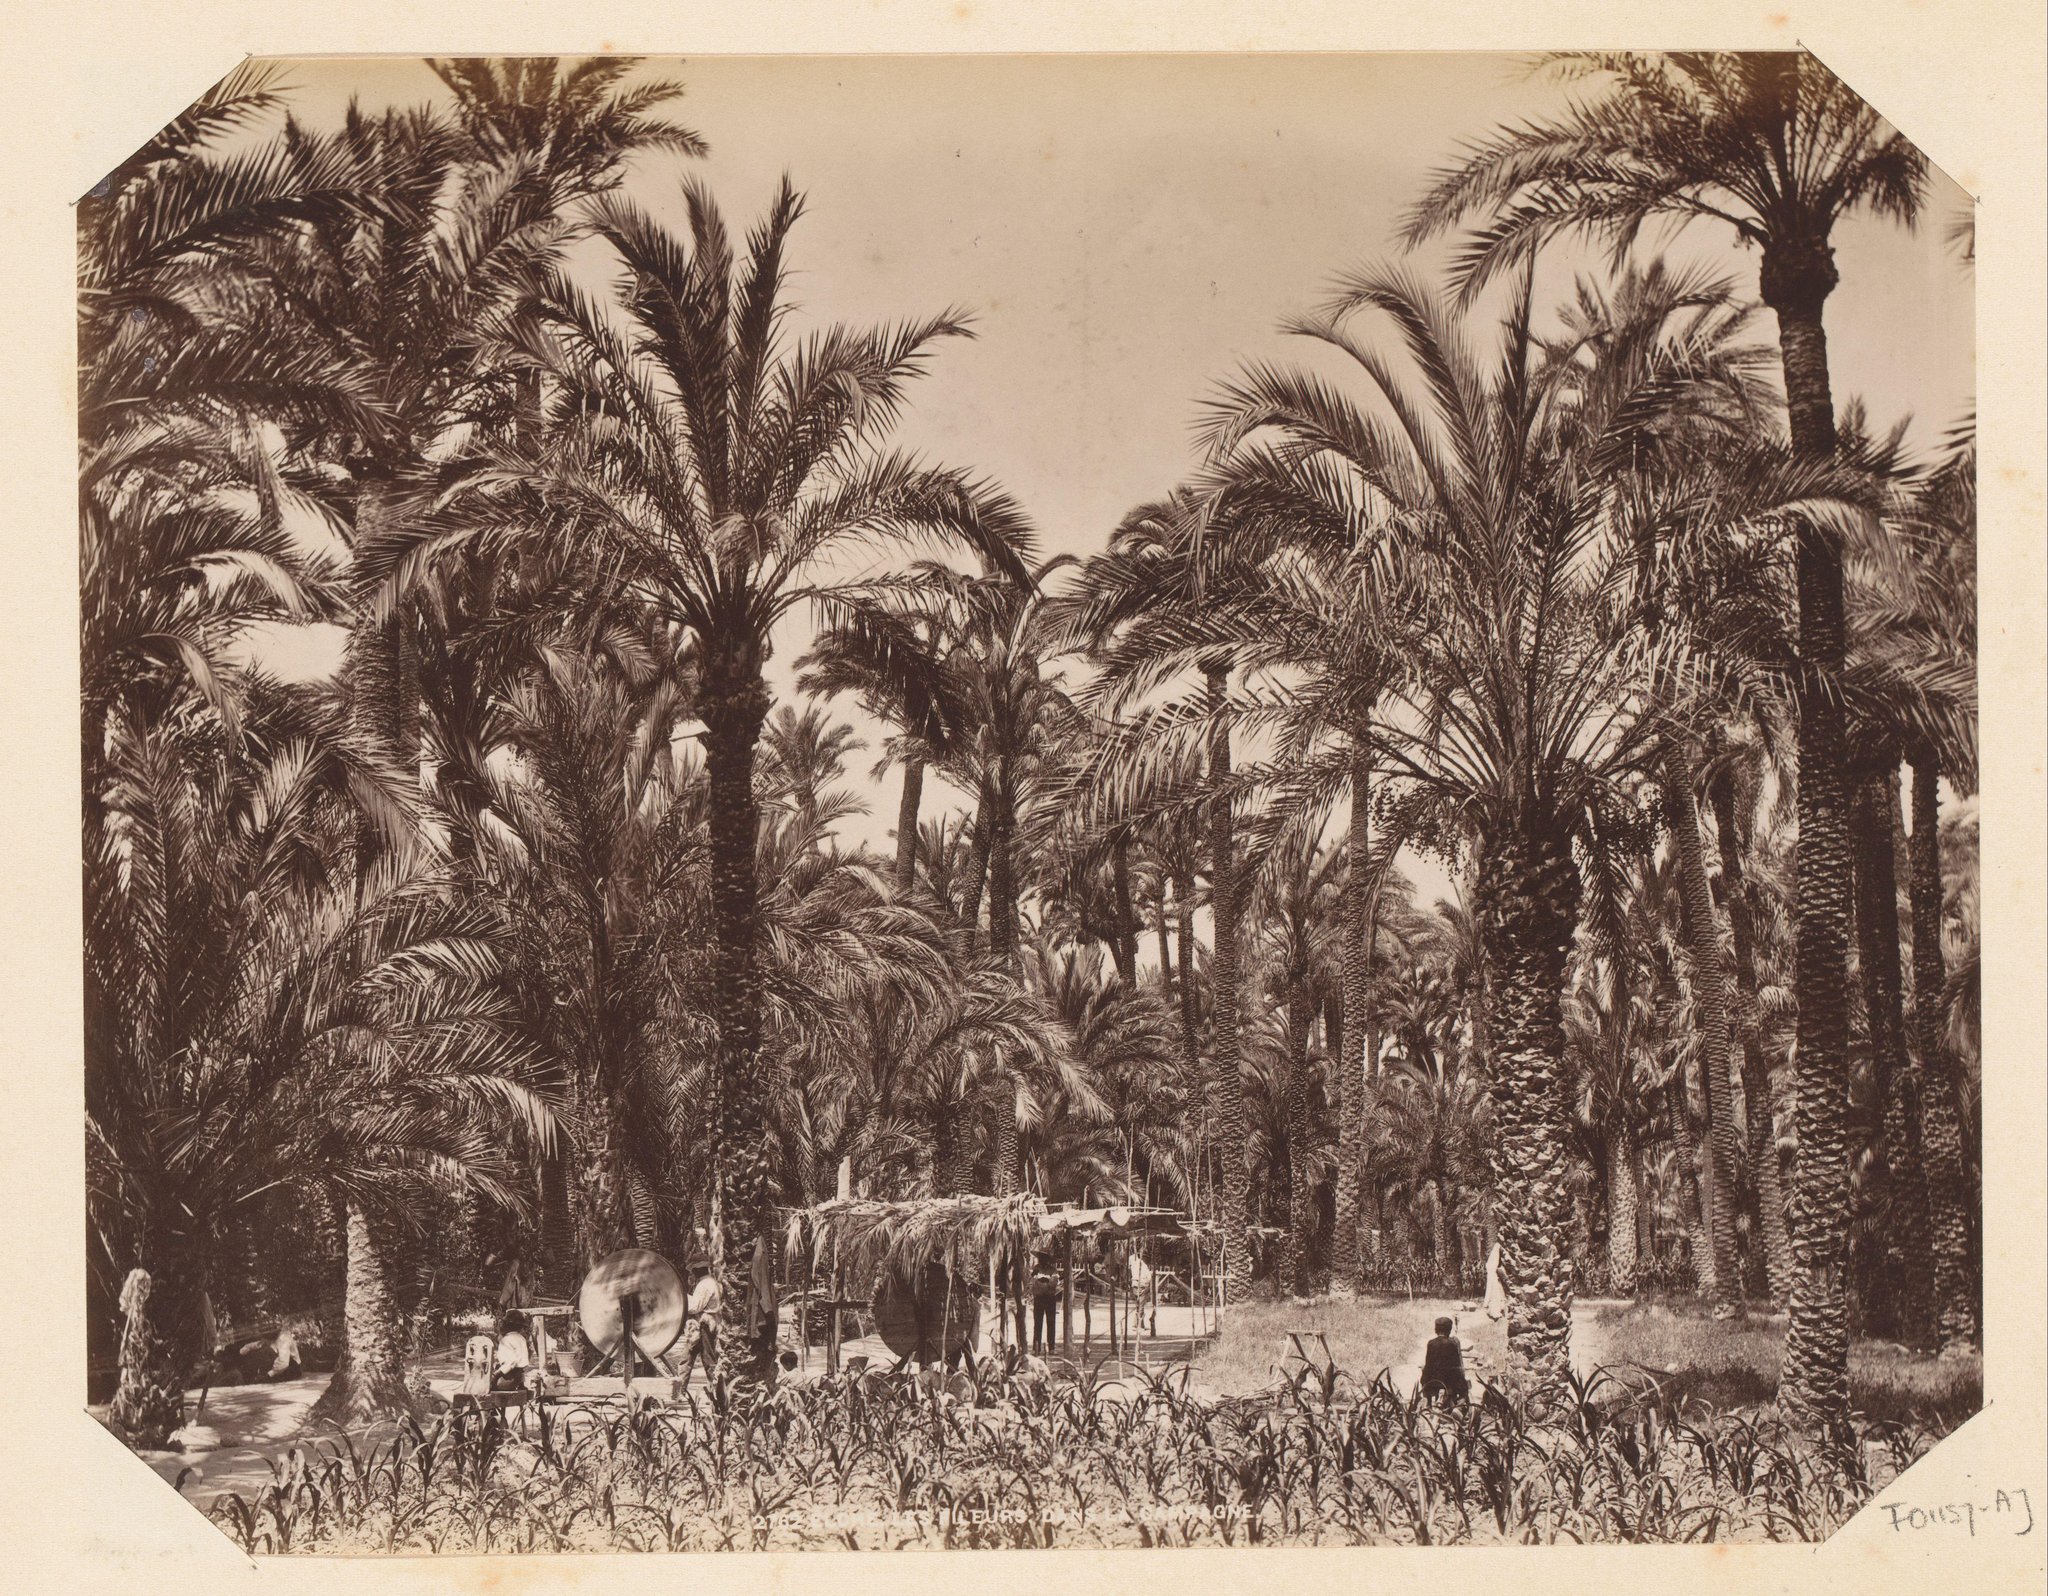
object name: album leaf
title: Elche, les fleurs dans la campagne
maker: Anonymous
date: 1885-1892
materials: photographic support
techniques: albumen print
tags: trees: palm-tree, elche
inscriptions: number: ‘2167’, annotation: ‘Landschap tusschen Murcia en Alicante’